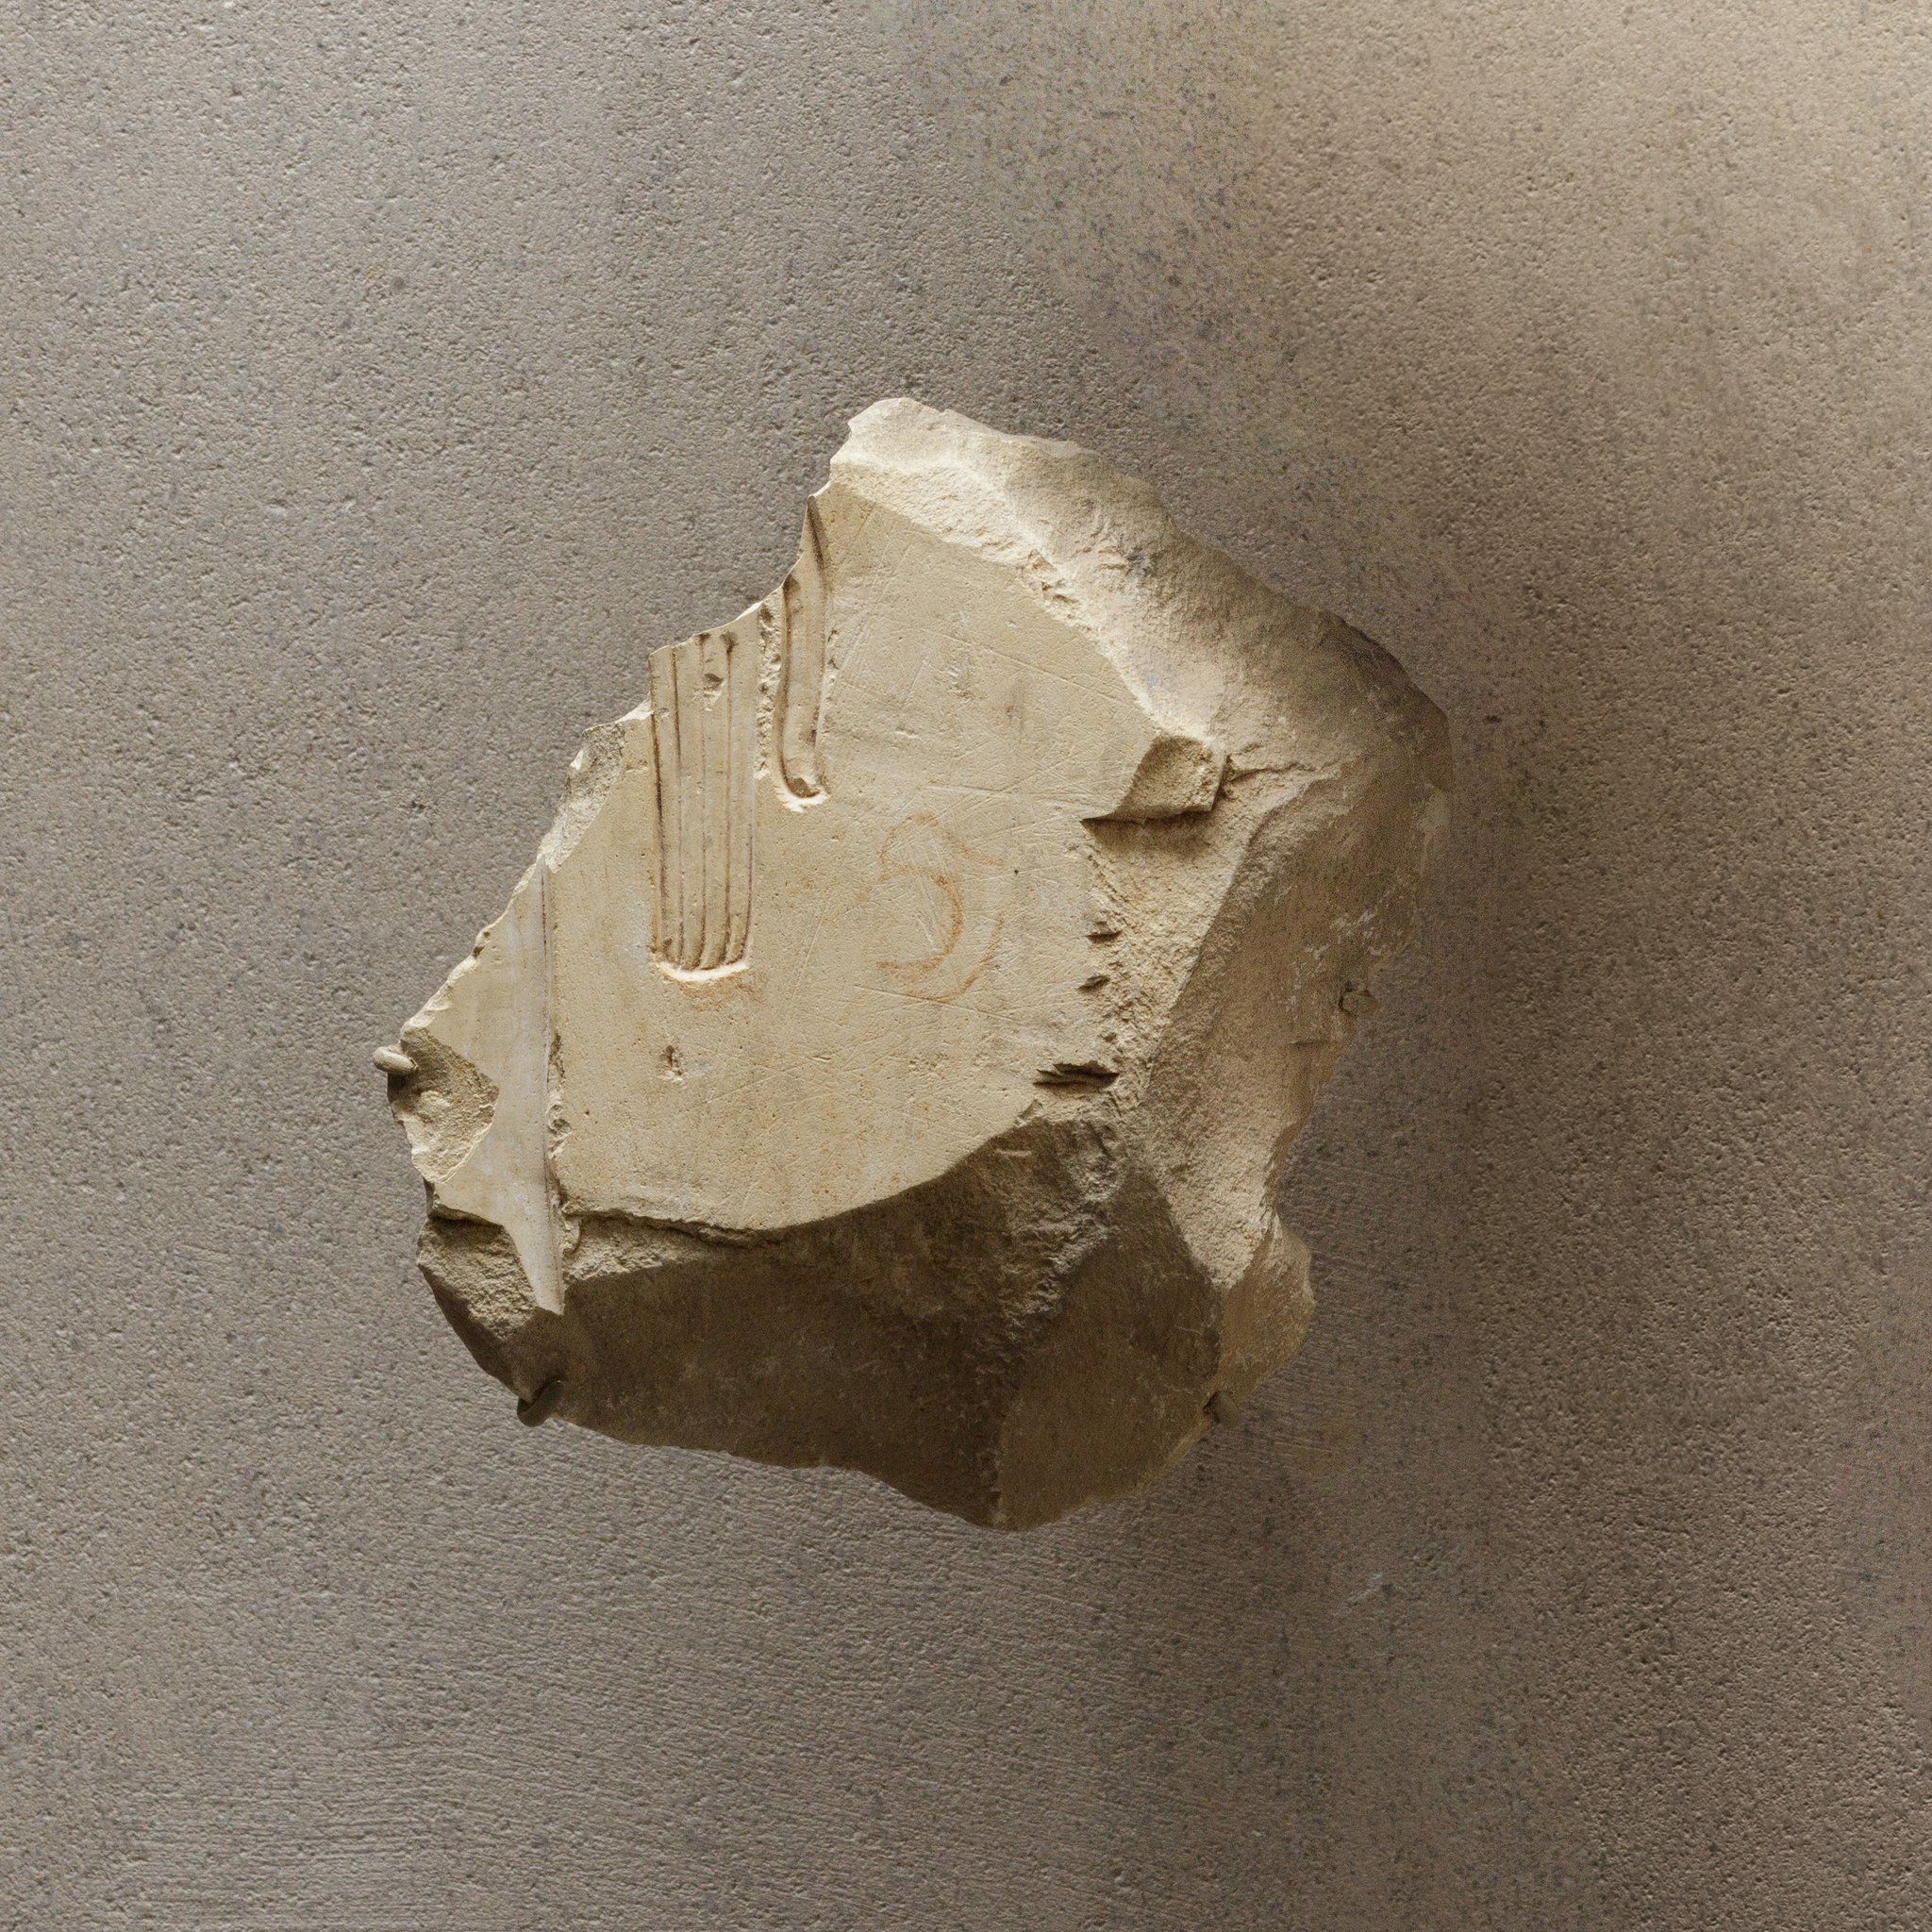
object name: relief fragment, tomb of neferu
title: Relief fragment from a procession of attendants - - see 31.3.1-1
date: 2051-2030 BCE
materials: limestone, paint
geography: egypt